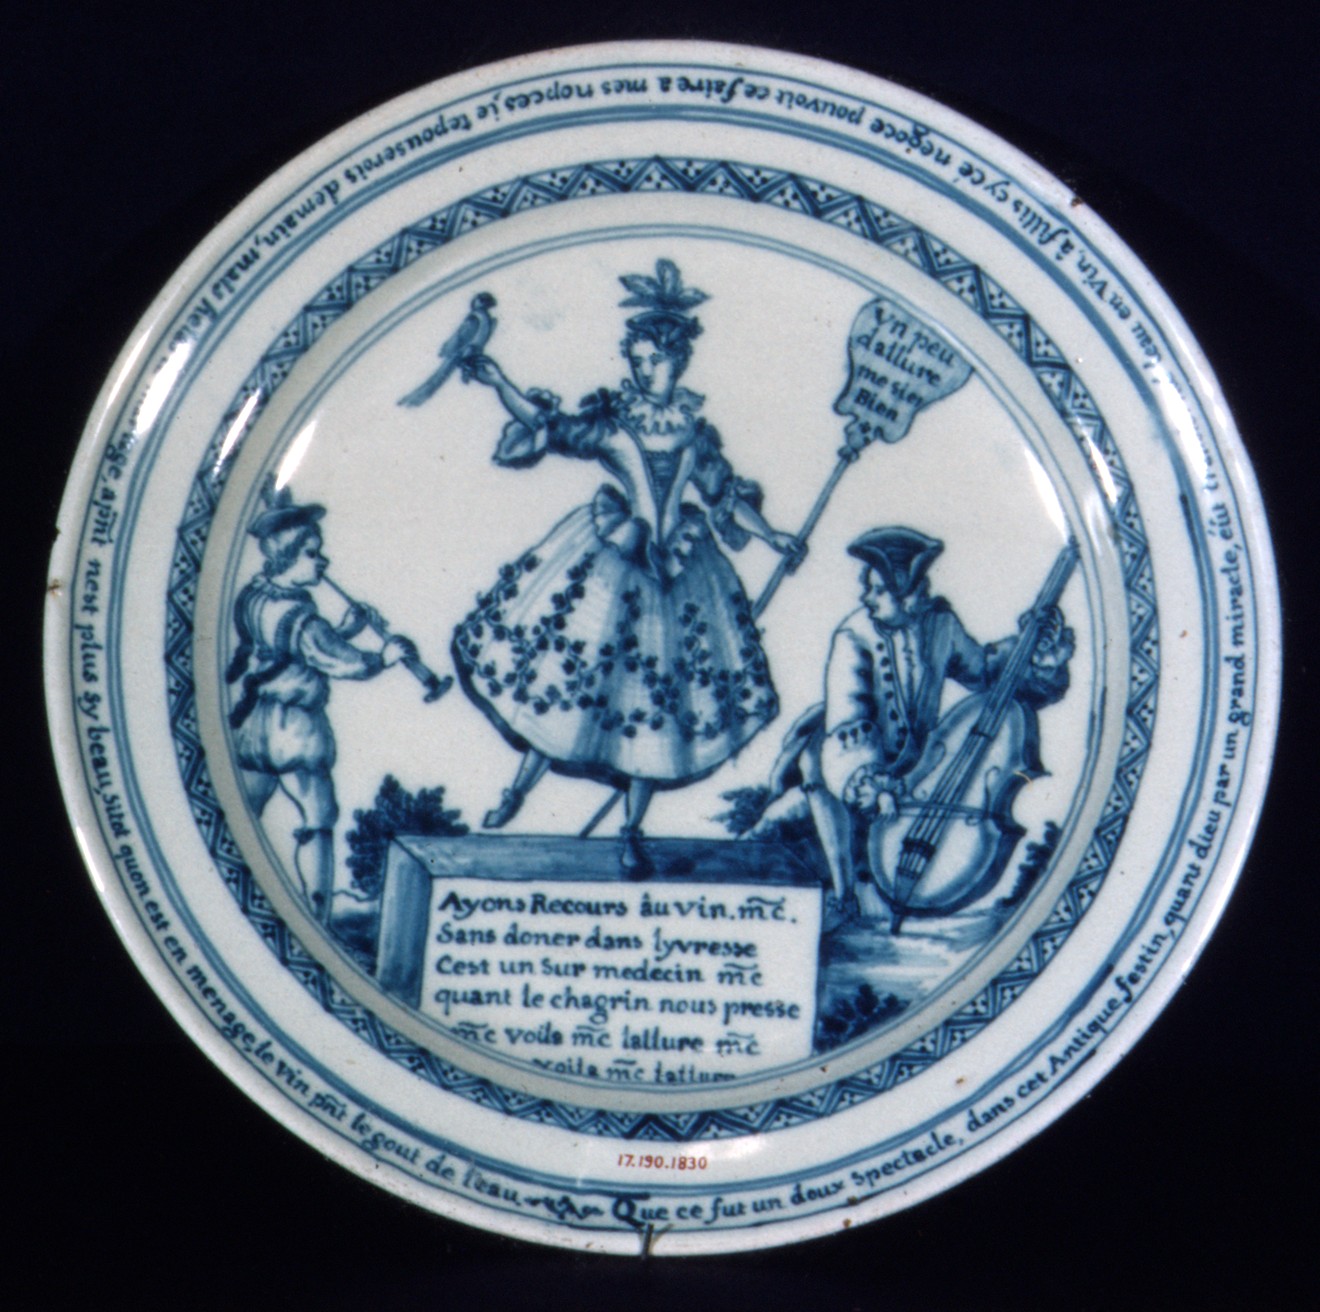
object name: plate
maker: laurent cars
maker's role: artist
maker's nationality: french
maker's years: 1699-1771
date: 1738-1749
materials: faience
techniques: glazing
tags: birds,men,women,violas